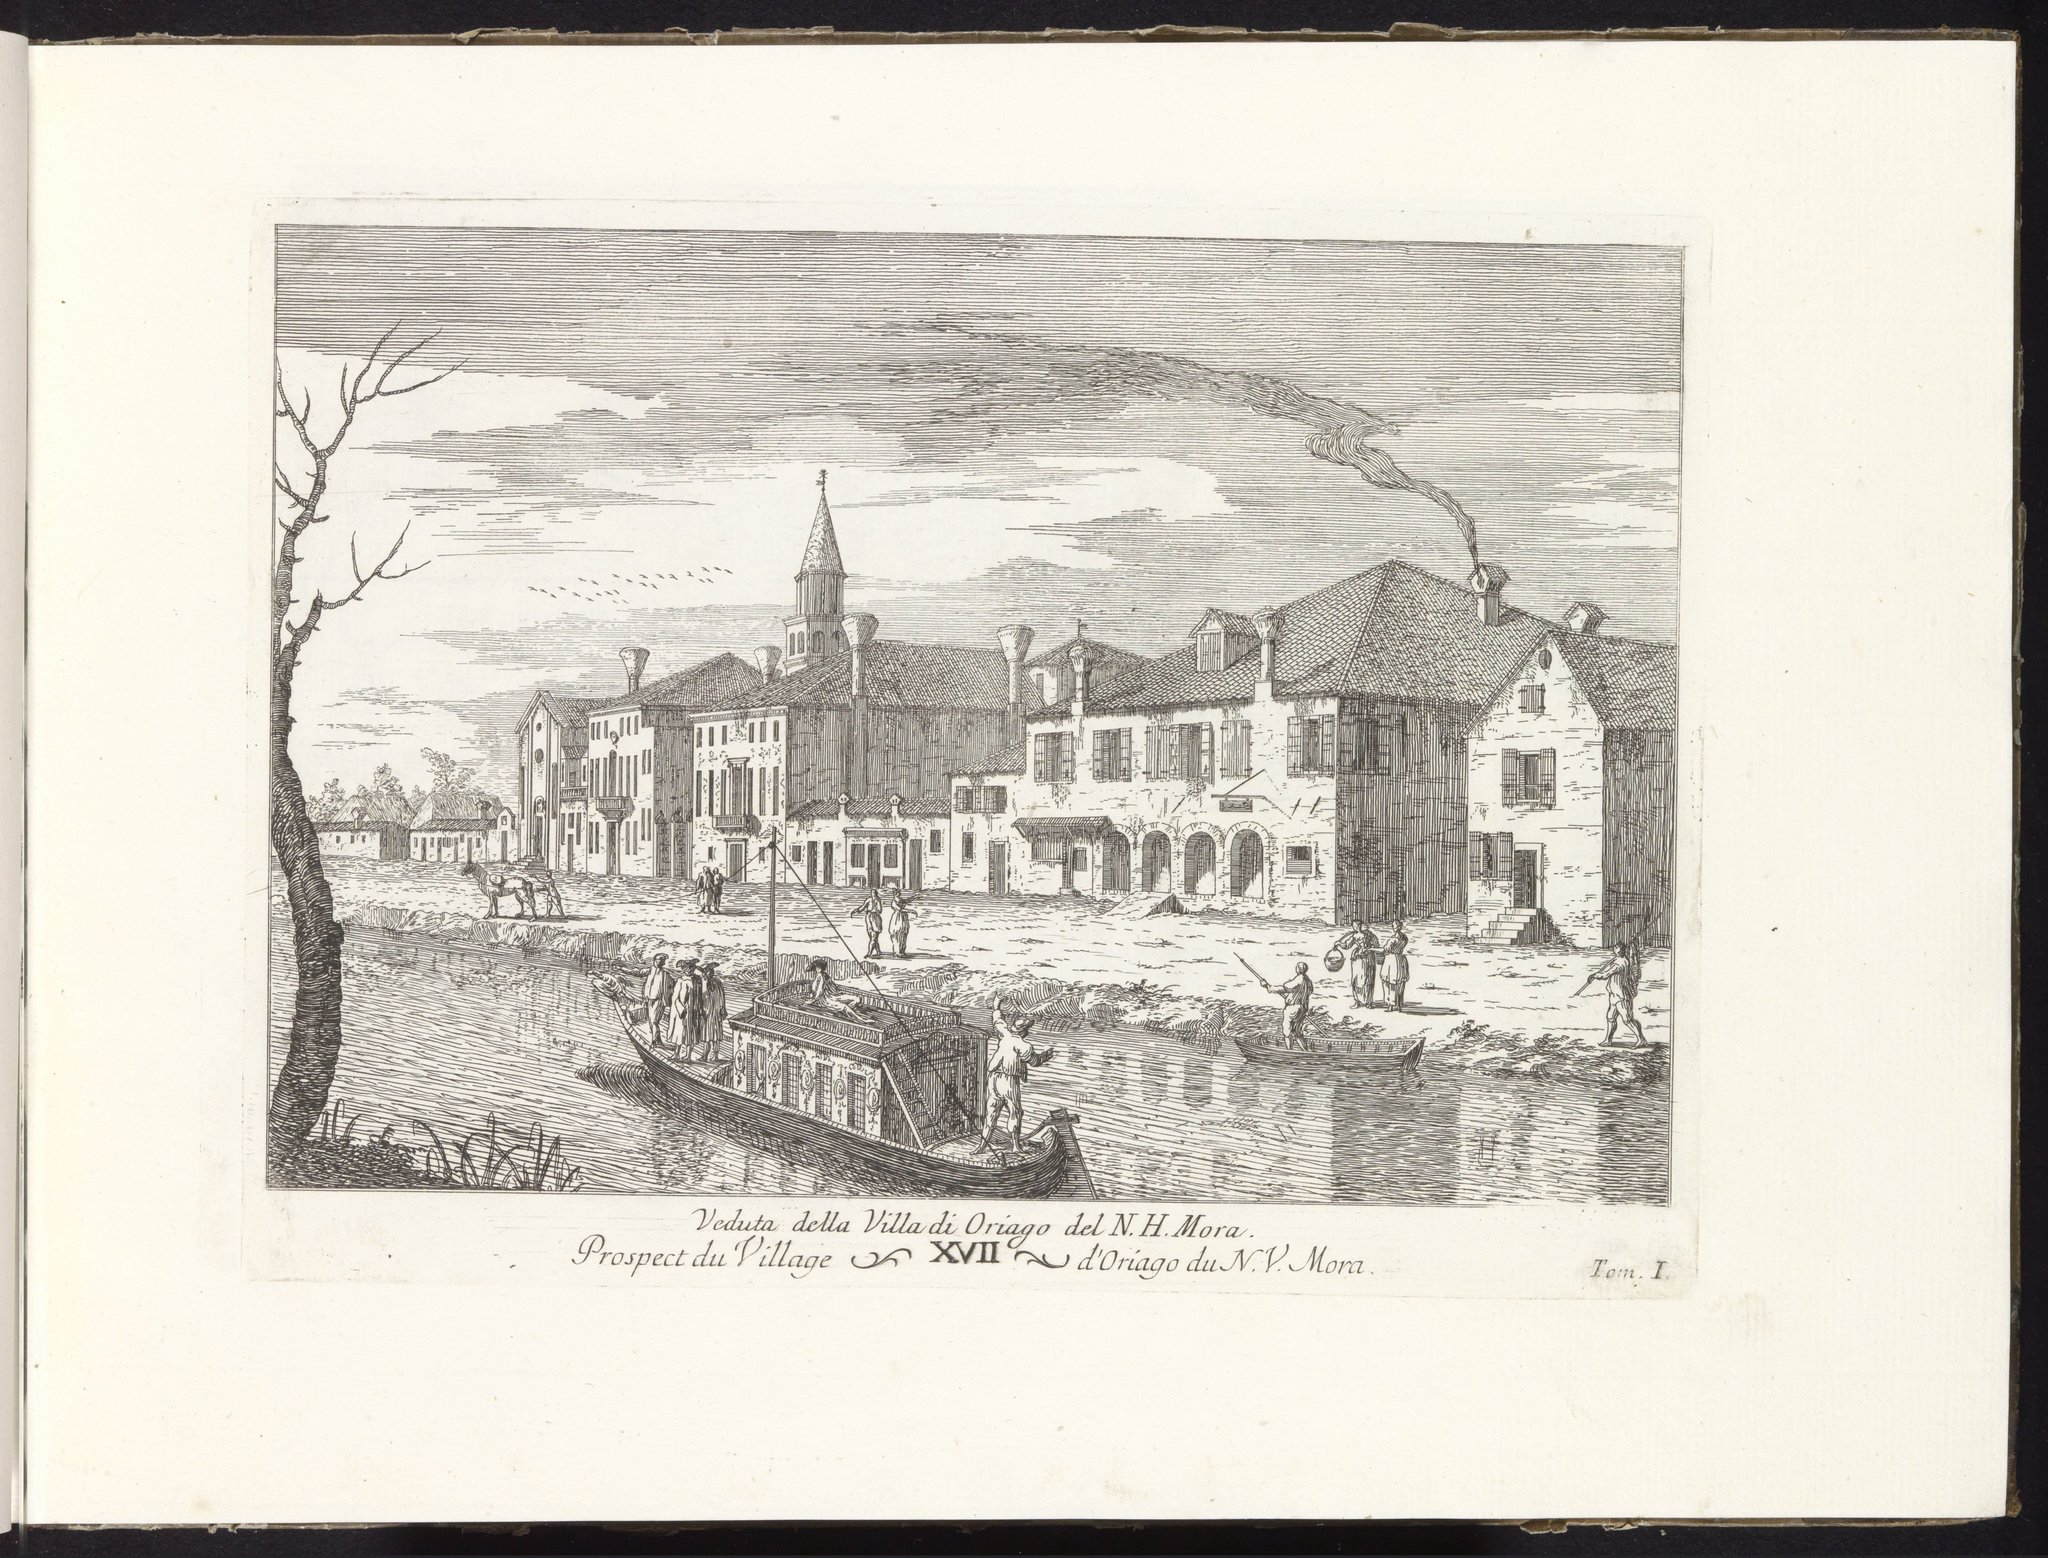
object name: print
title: Le delicie della Brenta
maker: giovanni francesco costa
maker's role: draughtsman, painter, print maker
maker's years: -1773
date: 1750-1760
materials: paper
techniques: etching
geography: italy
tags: river, tow-boat, towing-barge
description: Gezicht op de Villa di Oriago del N. H. Mora aan de rivier Brenta. Op het water vaart een trekschuit. Genummerd midden onder: XVII en rechtsonder: Tom: I. Deze prent maakt deel uit van een album.